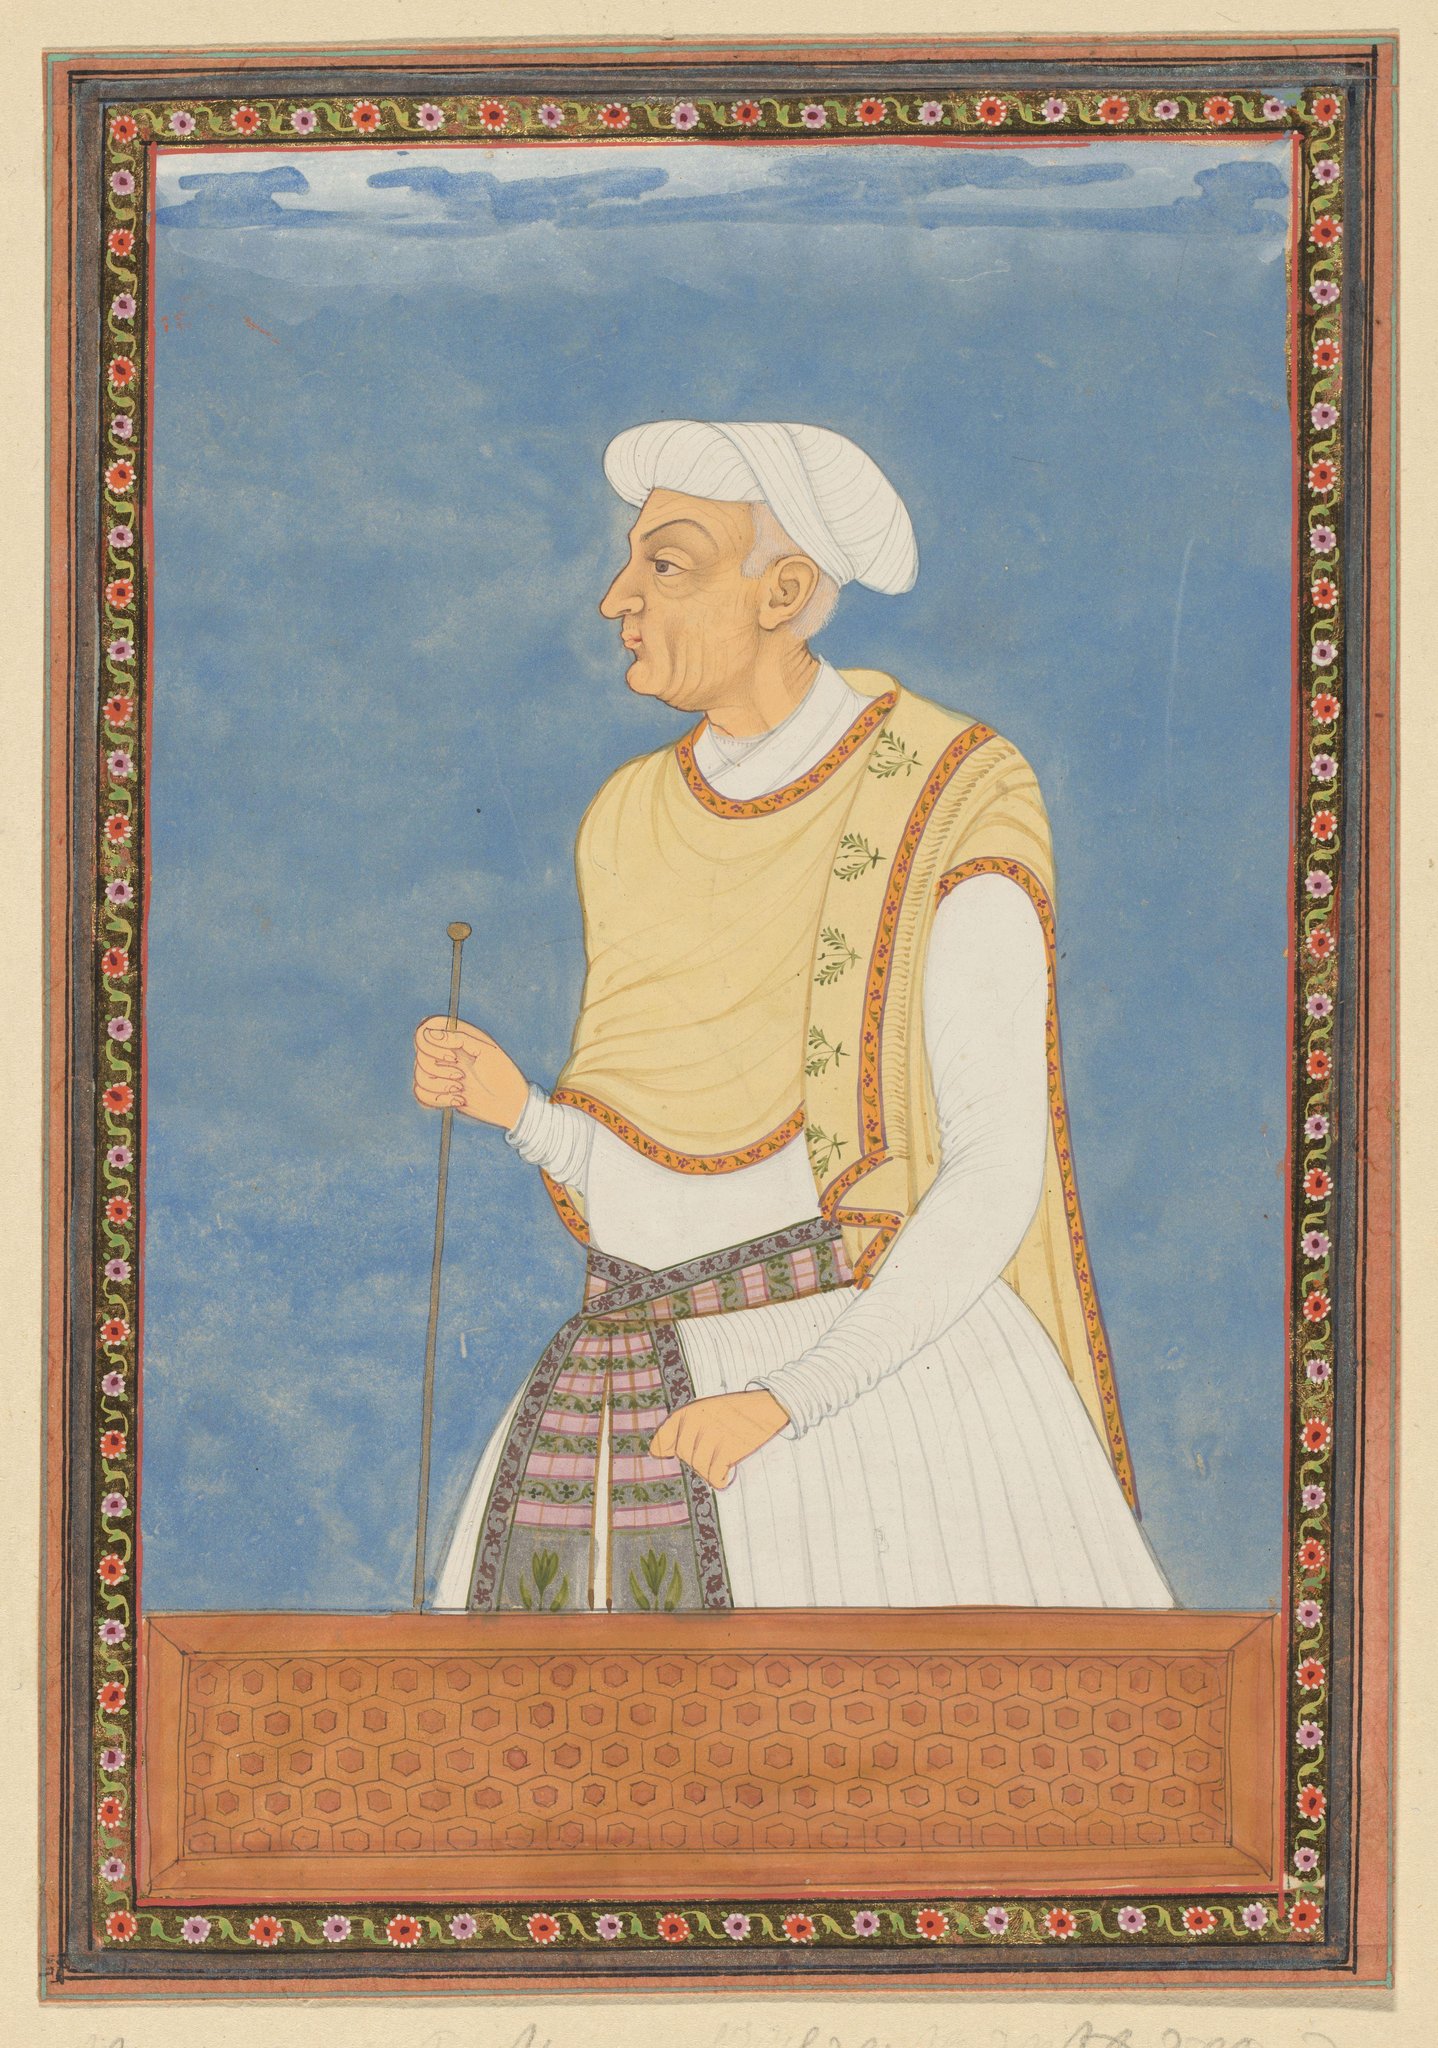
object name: indian miniature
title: Portret van Neknam-khan; hij is vizier van Sultan Abdullah geweest en heeft gediend als legeraanvoerder (sar-lashkar) van Karnatak na Mir Jumla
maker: Anonymous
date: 1686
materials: paint, gold leaf, gouache, paper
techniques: brush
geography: golkonda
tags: nicolaes cornelisz. witsen, historical person (...) - historical person (...) portrayed alone, ruler, sovereign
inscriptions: collector's mark: Lugt 1838, collector's mark: Lugt 240, annotation: ‘Miknamechan Visir van Sultan Abdulla’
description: Neknam-khan is tot aan zijn heupen afgebeeld, naar links gewend, in zijn linker hand een staf. Blad 25 in het `Witsen-Album', met 49 Indiase miniaturen van vorsten. Boven het portret een stukje papier met de naam in het Perzisch. Onder het portret een stukje papier met de naam in het Portugees.